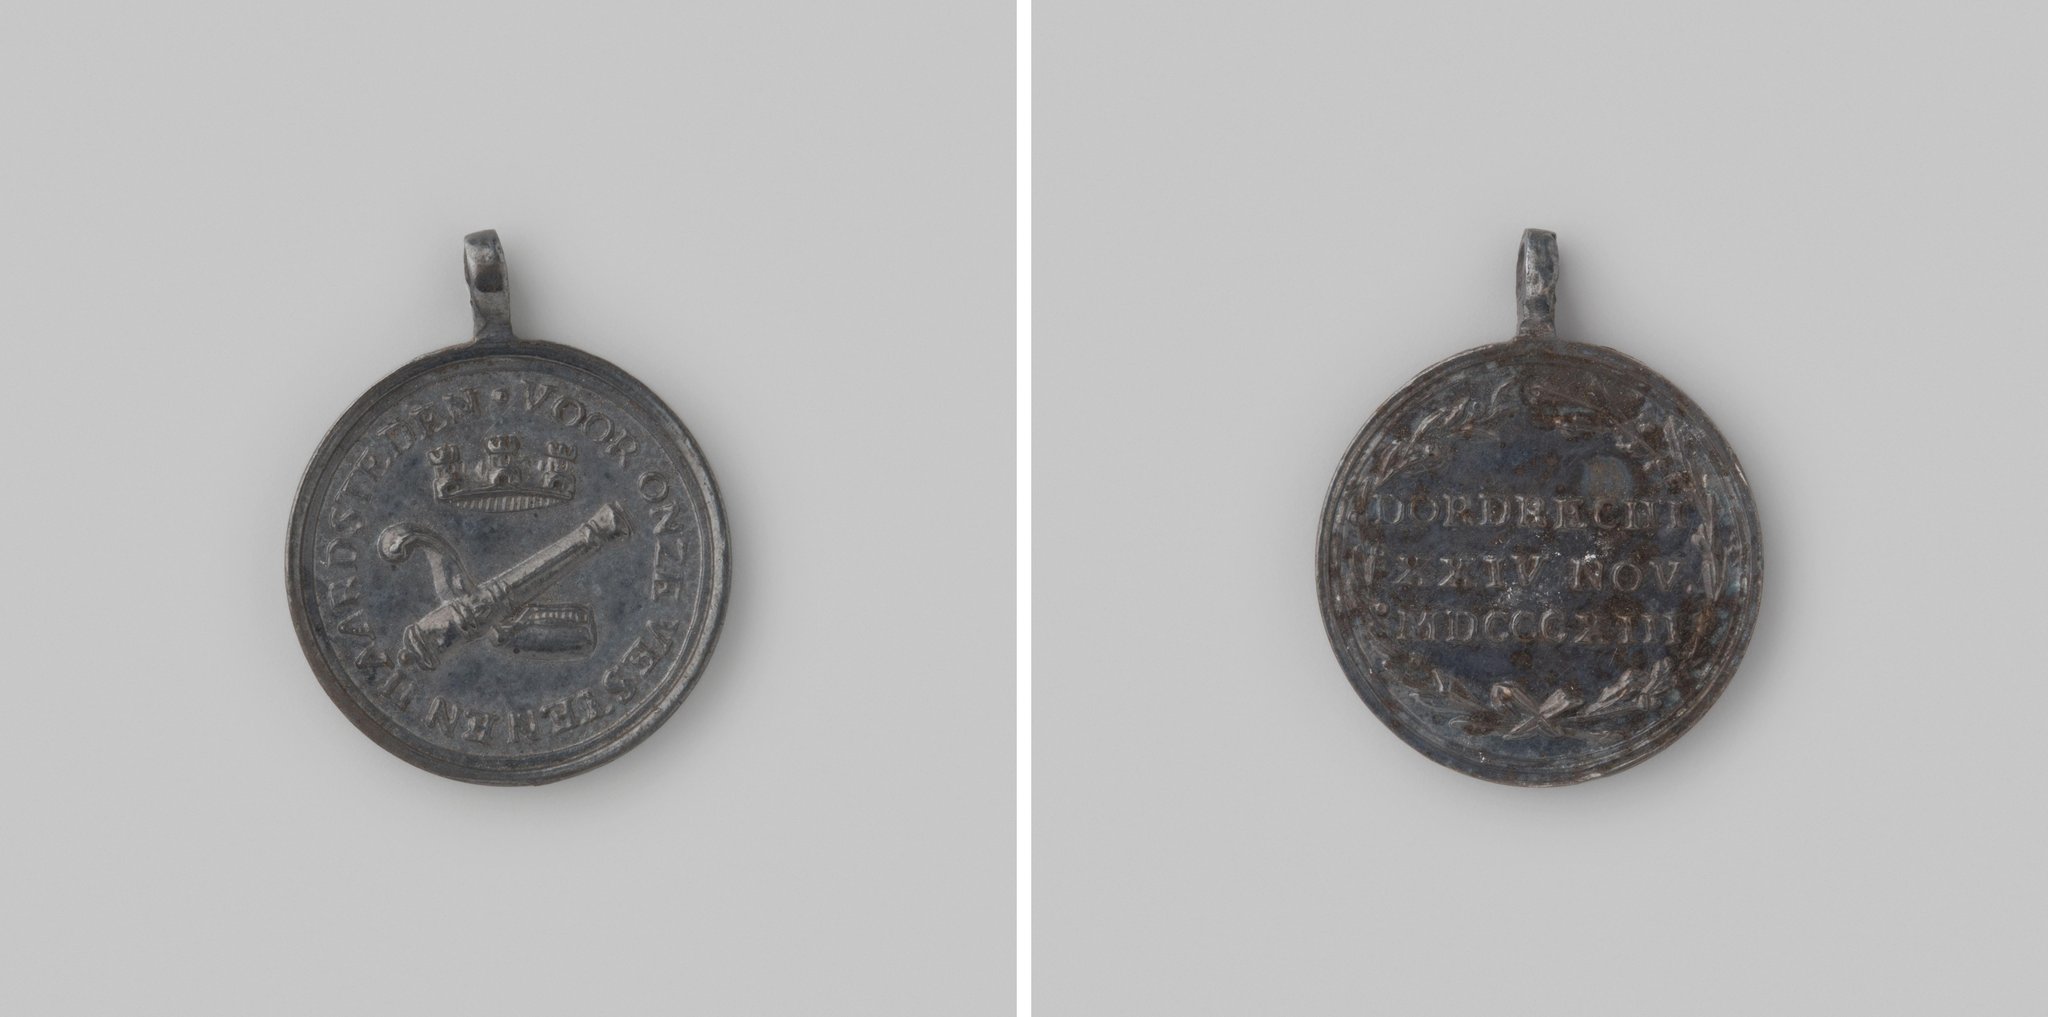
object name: honorary medal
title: Erepenning van de Dordrechtse vrijwilligers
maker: Anonymous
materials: silver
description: Zilveren draagpenning met oog en ring, klein model.